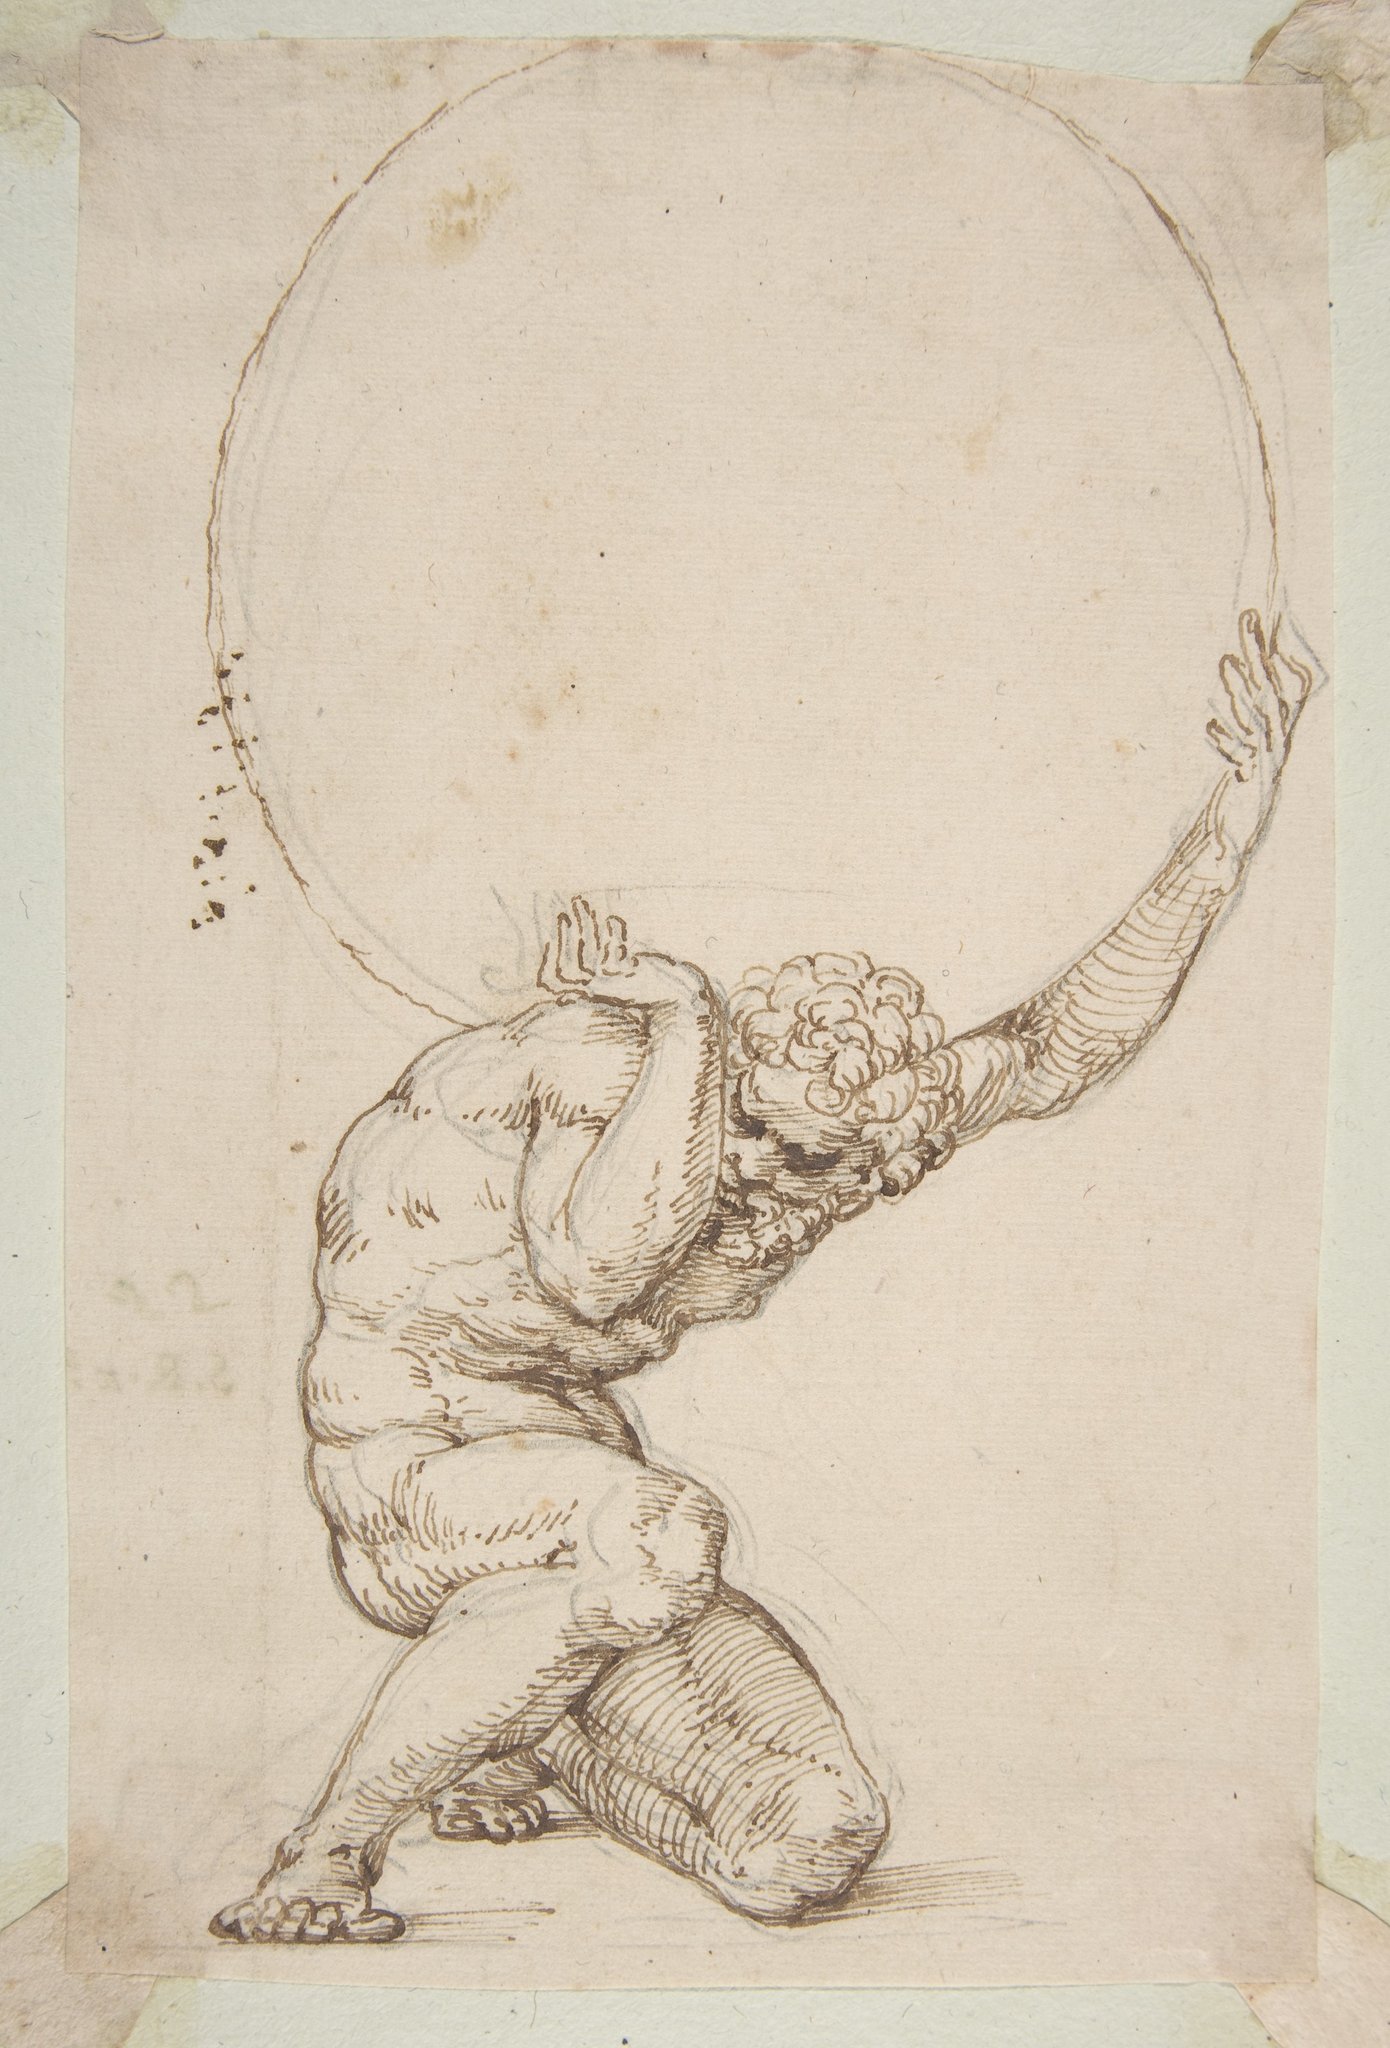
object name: drawing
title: Crouching Figure of Atlas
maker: baldassarre tommaso peruzzi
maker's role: artist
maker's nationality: italian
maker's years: 1481-1536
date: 1481-1536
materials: chalk, ink, drawing material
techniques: pen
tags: male nudes